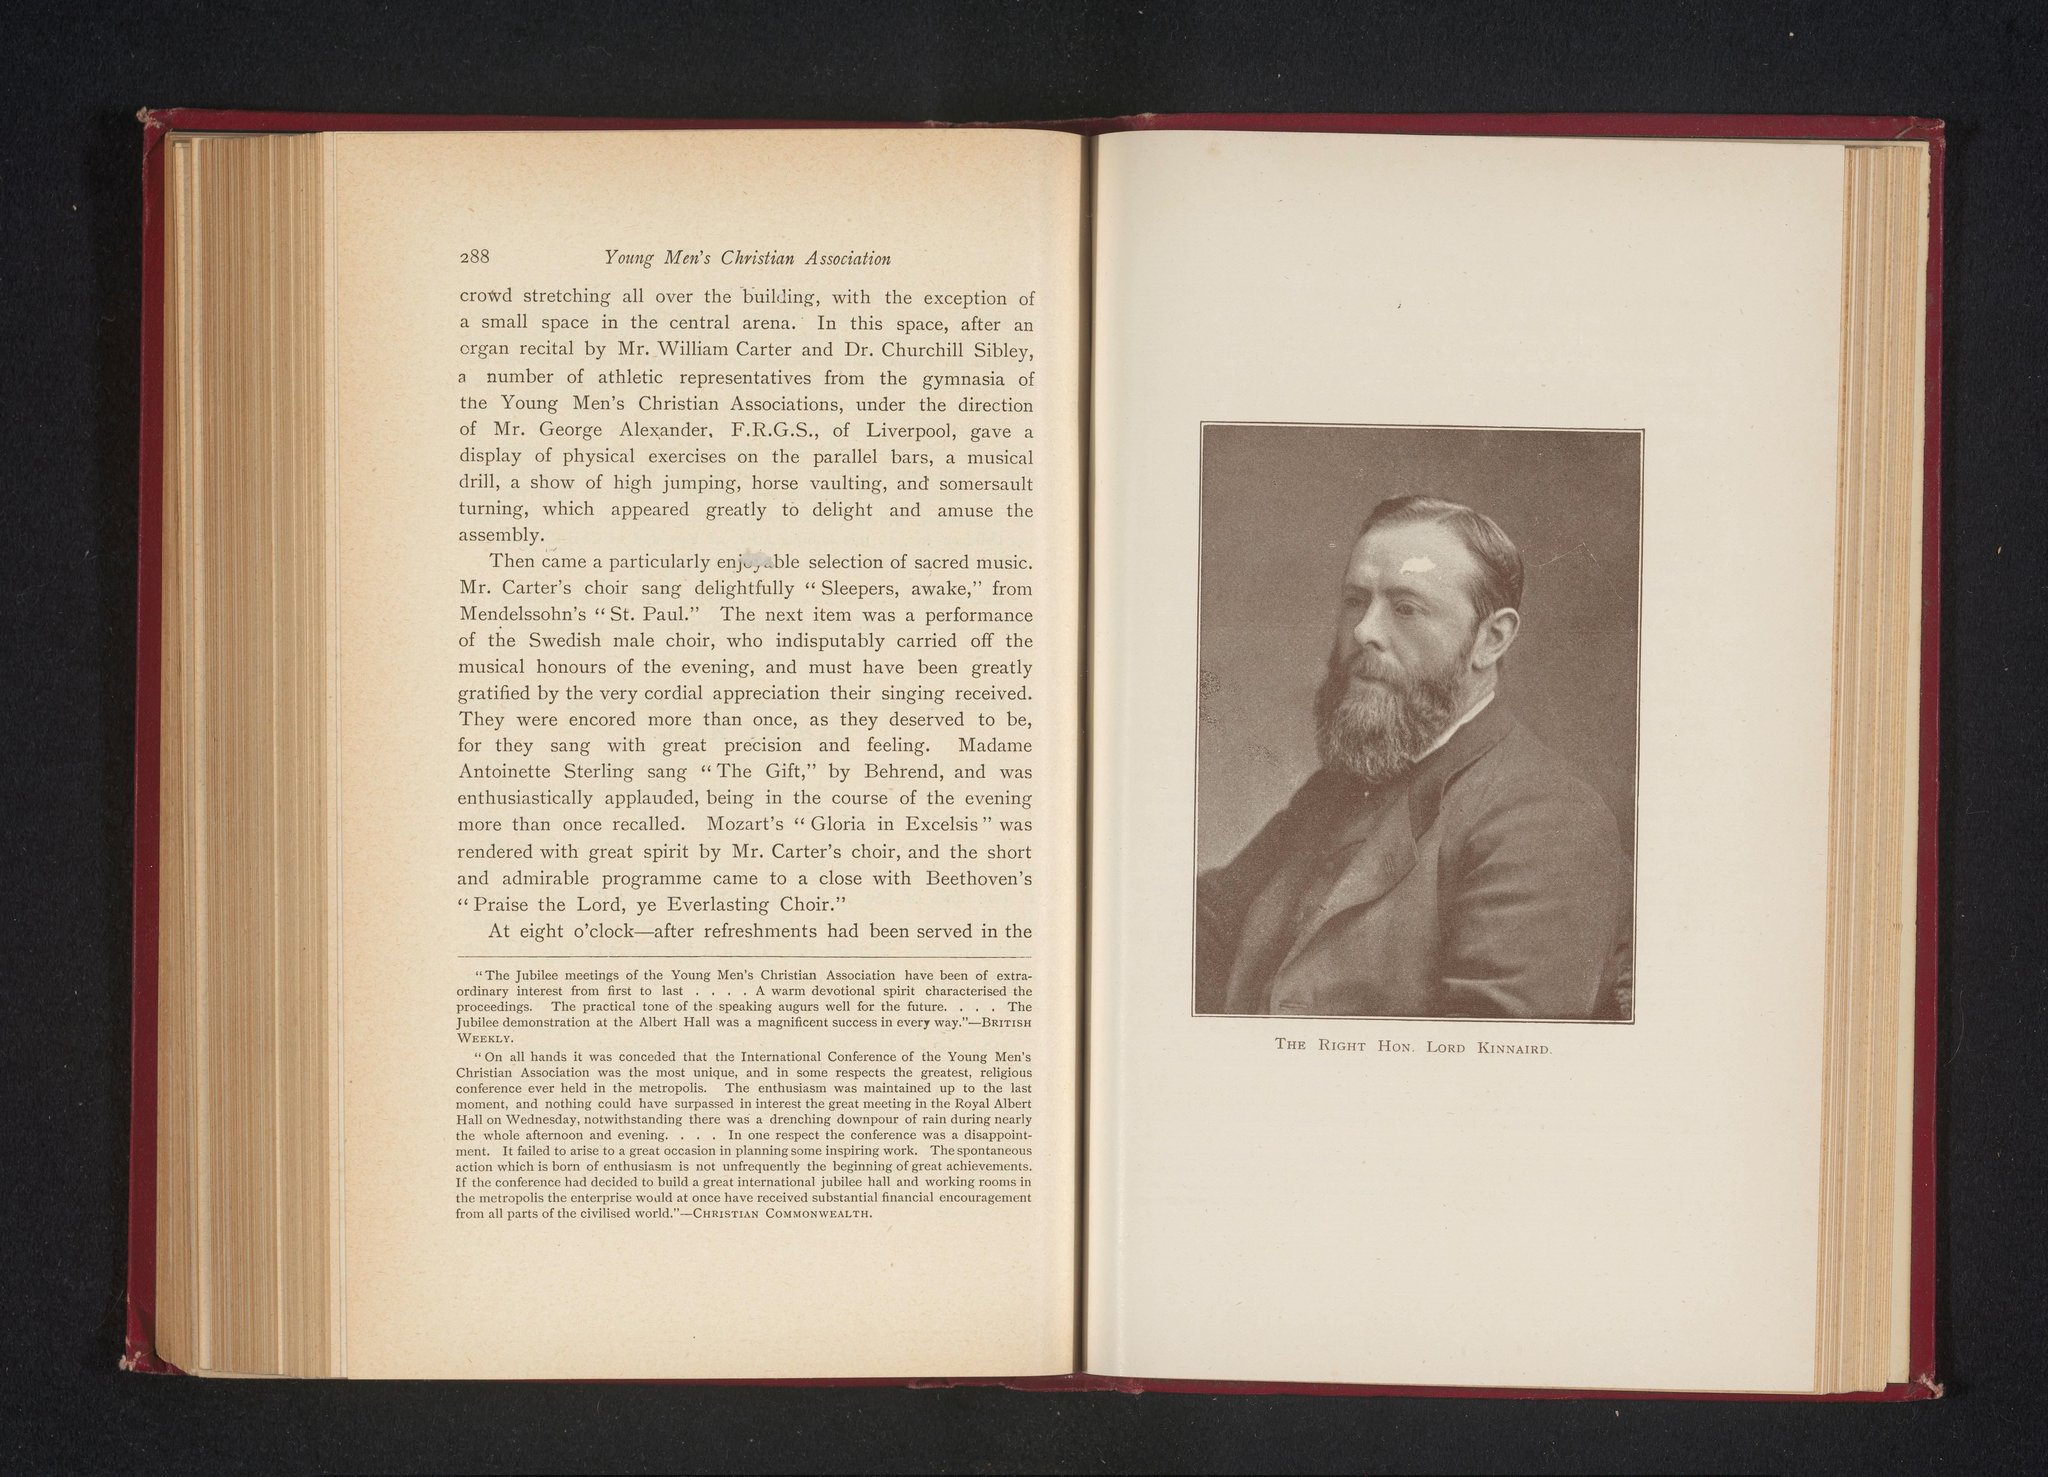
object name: photomechanical print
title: Portret van Arthur Kinnaird, elfde Lord Kinnaird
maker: Anonymous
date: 1890-1895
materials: paper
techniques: autotype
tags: historical persons